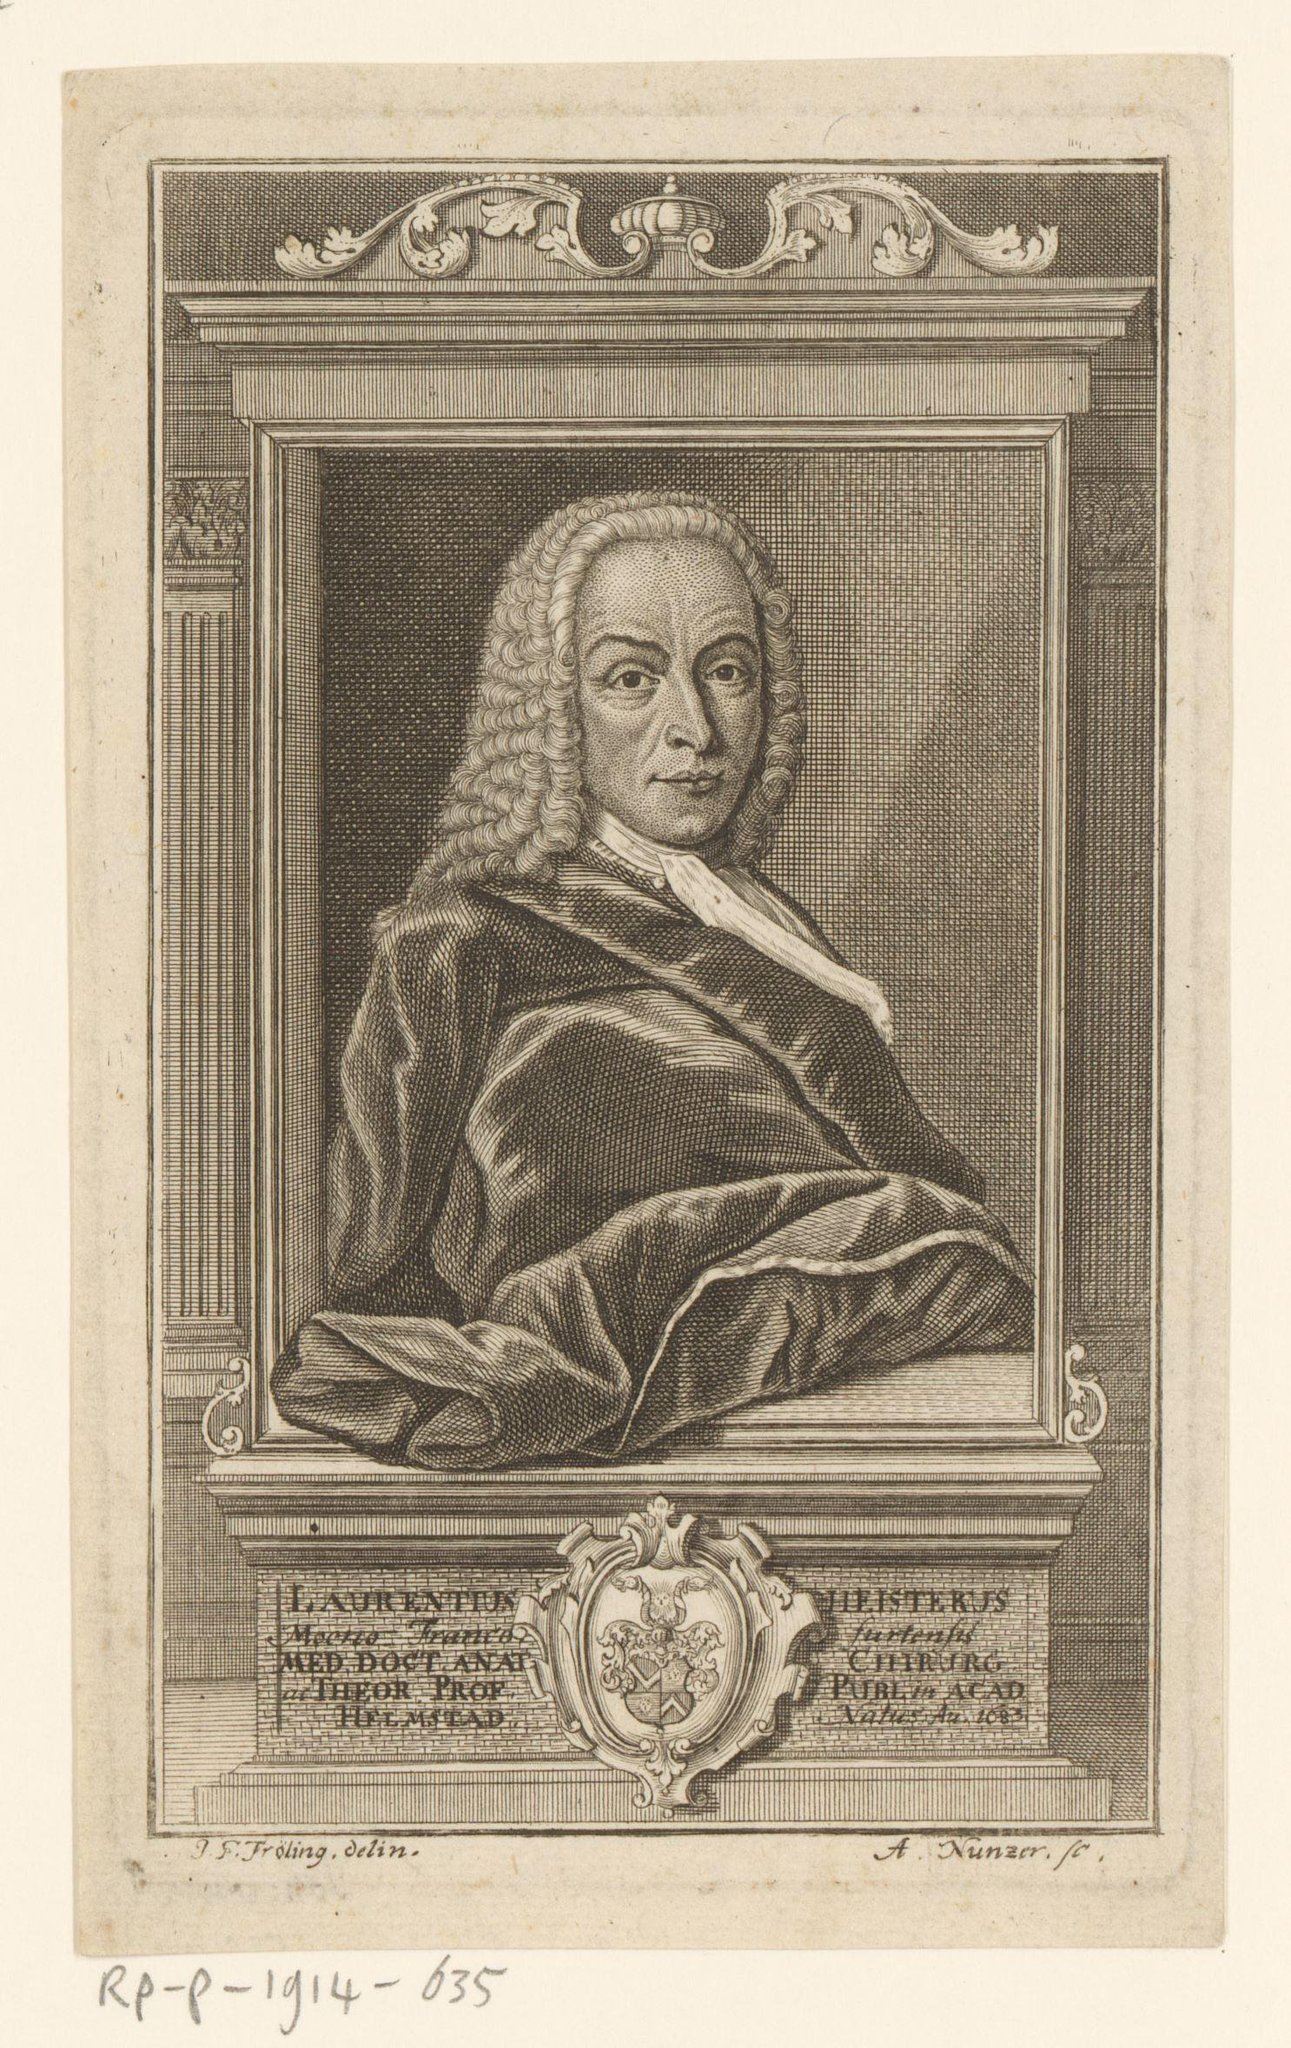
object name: print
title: Portret van Lorenz Heister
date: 1700-1749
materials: paper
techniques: engraving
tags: historical persons, armorial bearing, heraldry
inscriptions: collector's mark: Lugt 2228